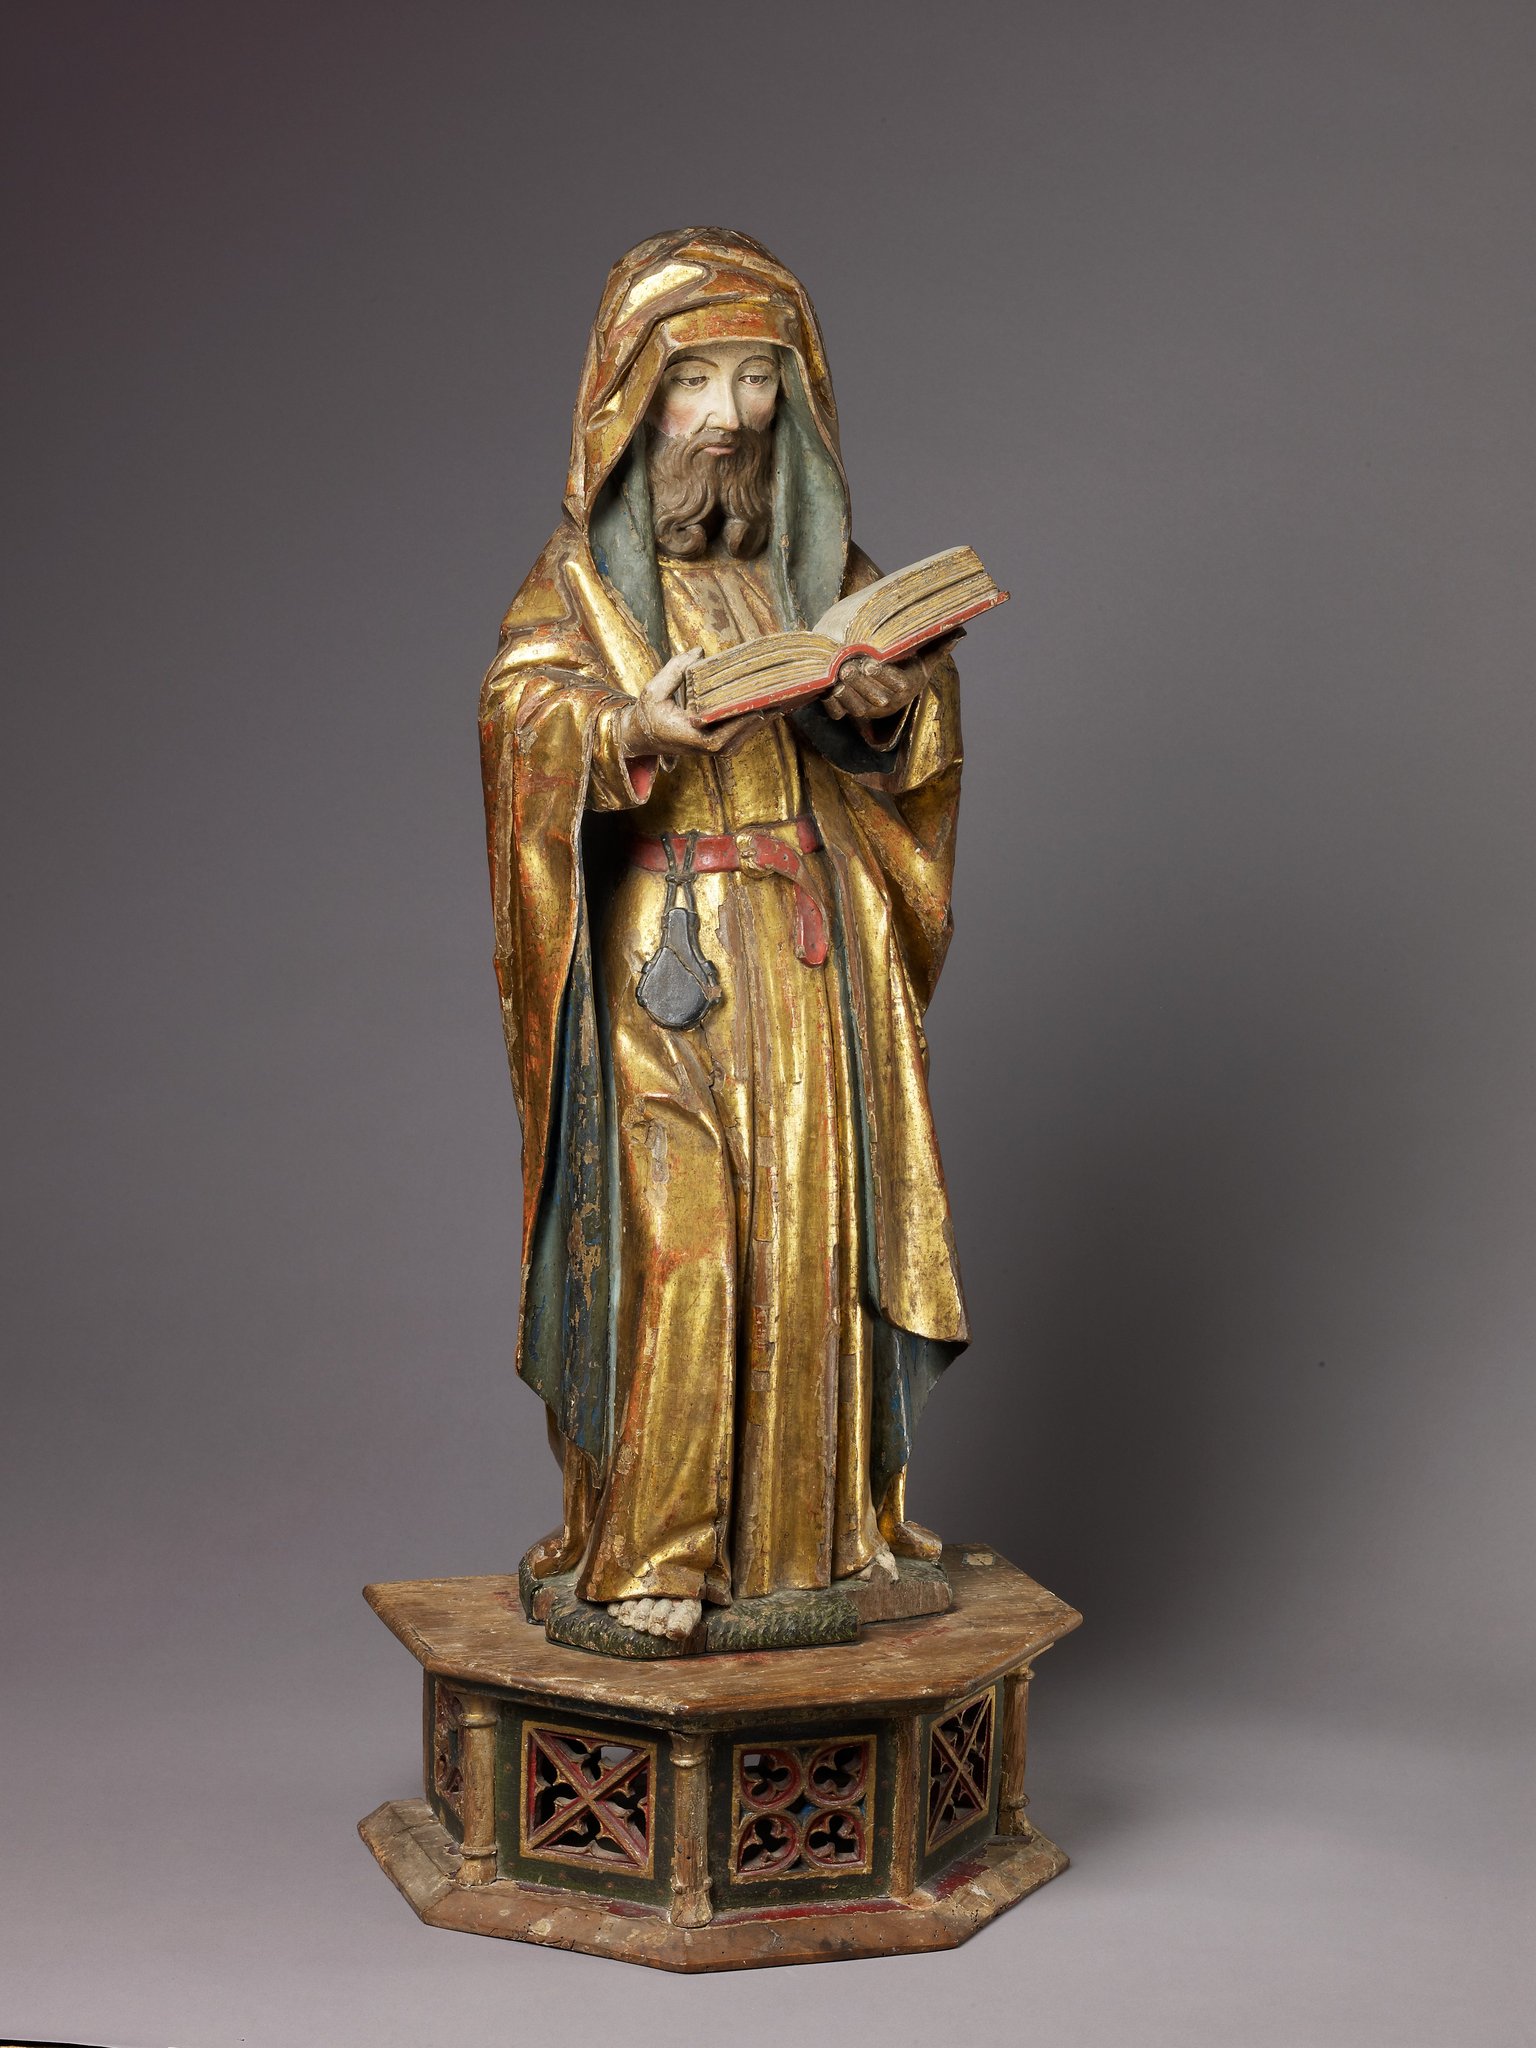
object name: statue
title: Saint Matthew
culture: brabant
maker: brabant (diest or leuven?)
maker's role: artist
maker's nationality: brabant (diest or leuven?)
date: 1470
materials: wood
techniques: gilding, polychromy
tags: saint matthew